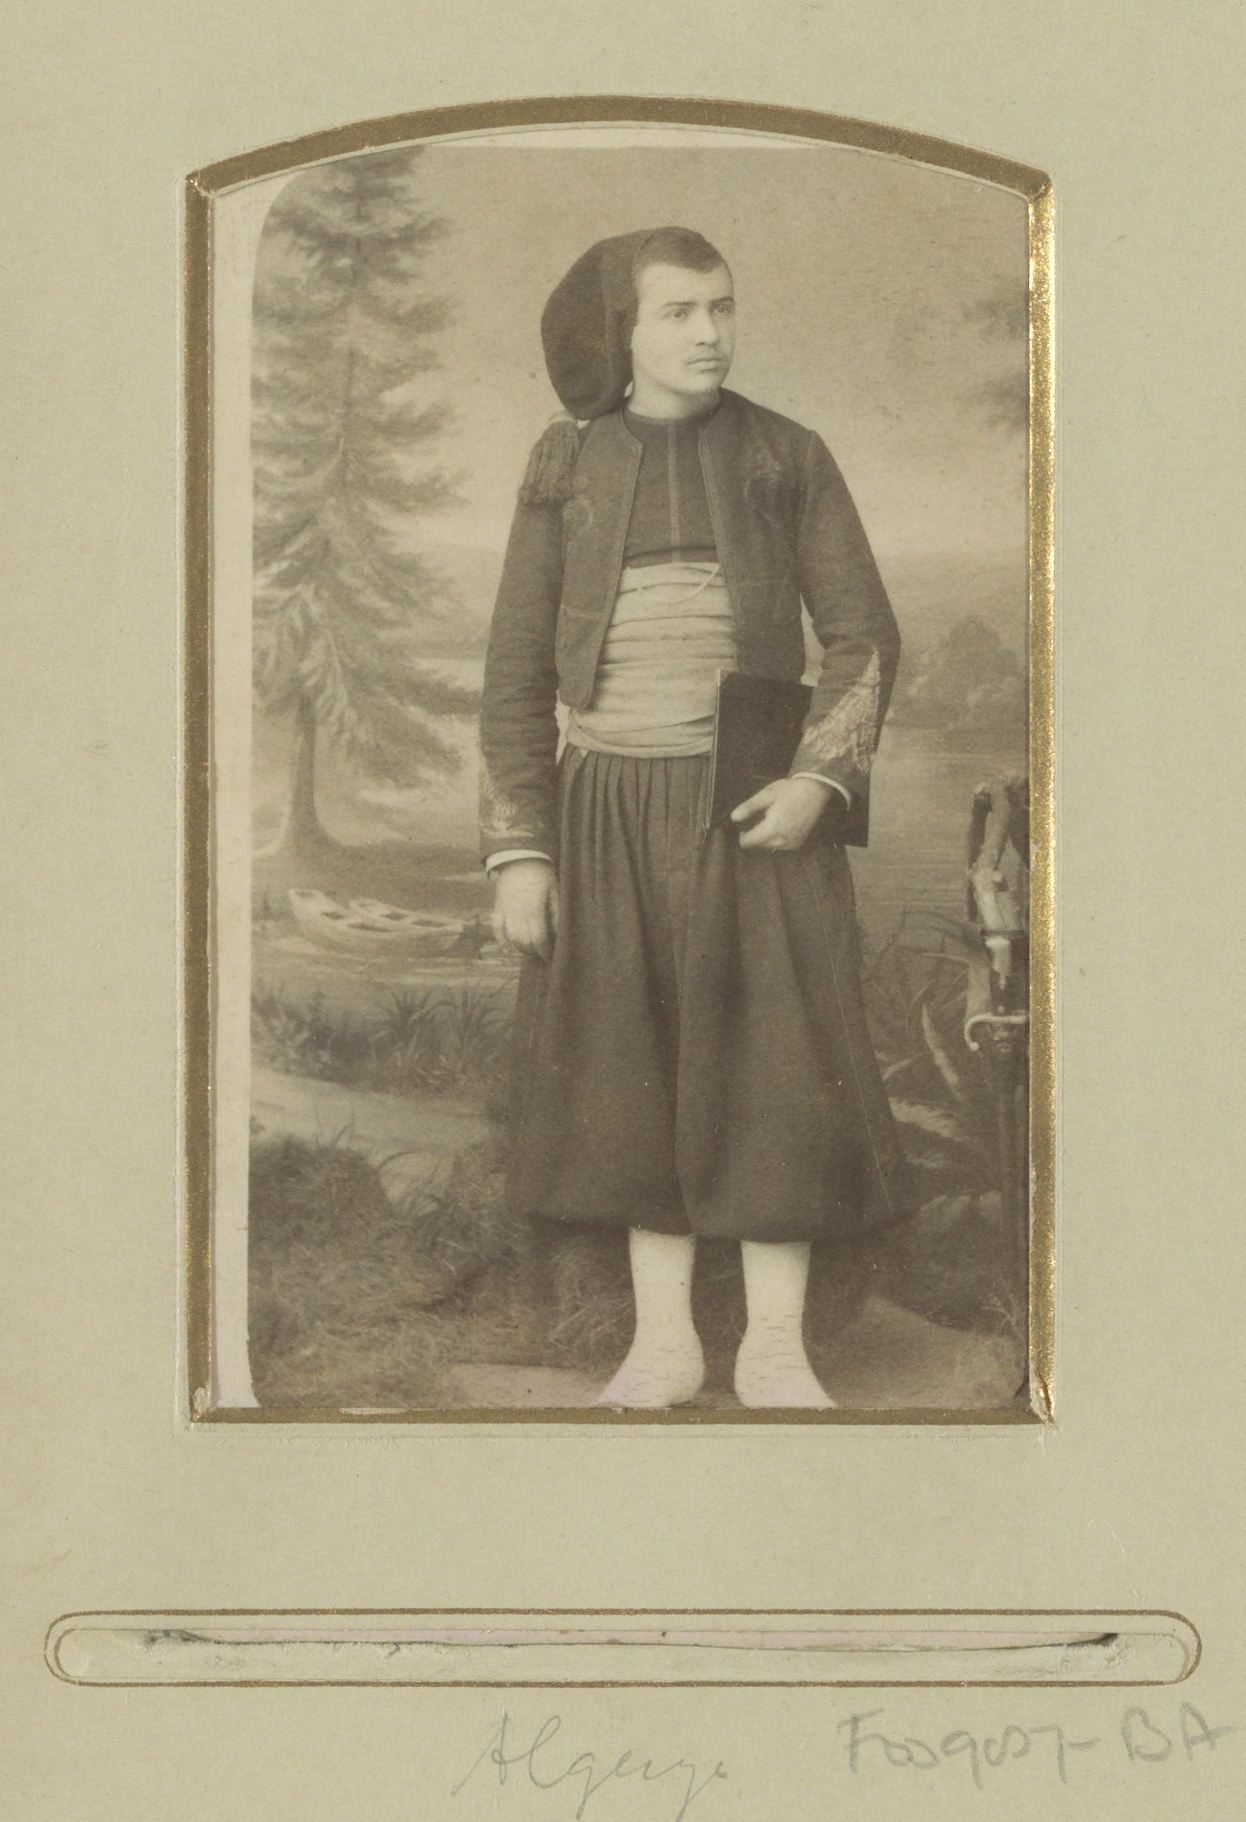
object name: carte de visite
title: Portret van een Algerijnse zoeaaf, staand met boek in de hand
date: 1870-1900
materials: cardboard, paper, photographic support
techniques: albumen print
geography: algiers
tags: head-gear: cap, warfare; military affairs, (military) uniforms, division of armed forces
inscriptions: address: ‘5, Boulevard de la République, 5, Alger’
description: Onderdeel van Album met cartes-de-visite en kabinetfoto's van militairen in uniform.